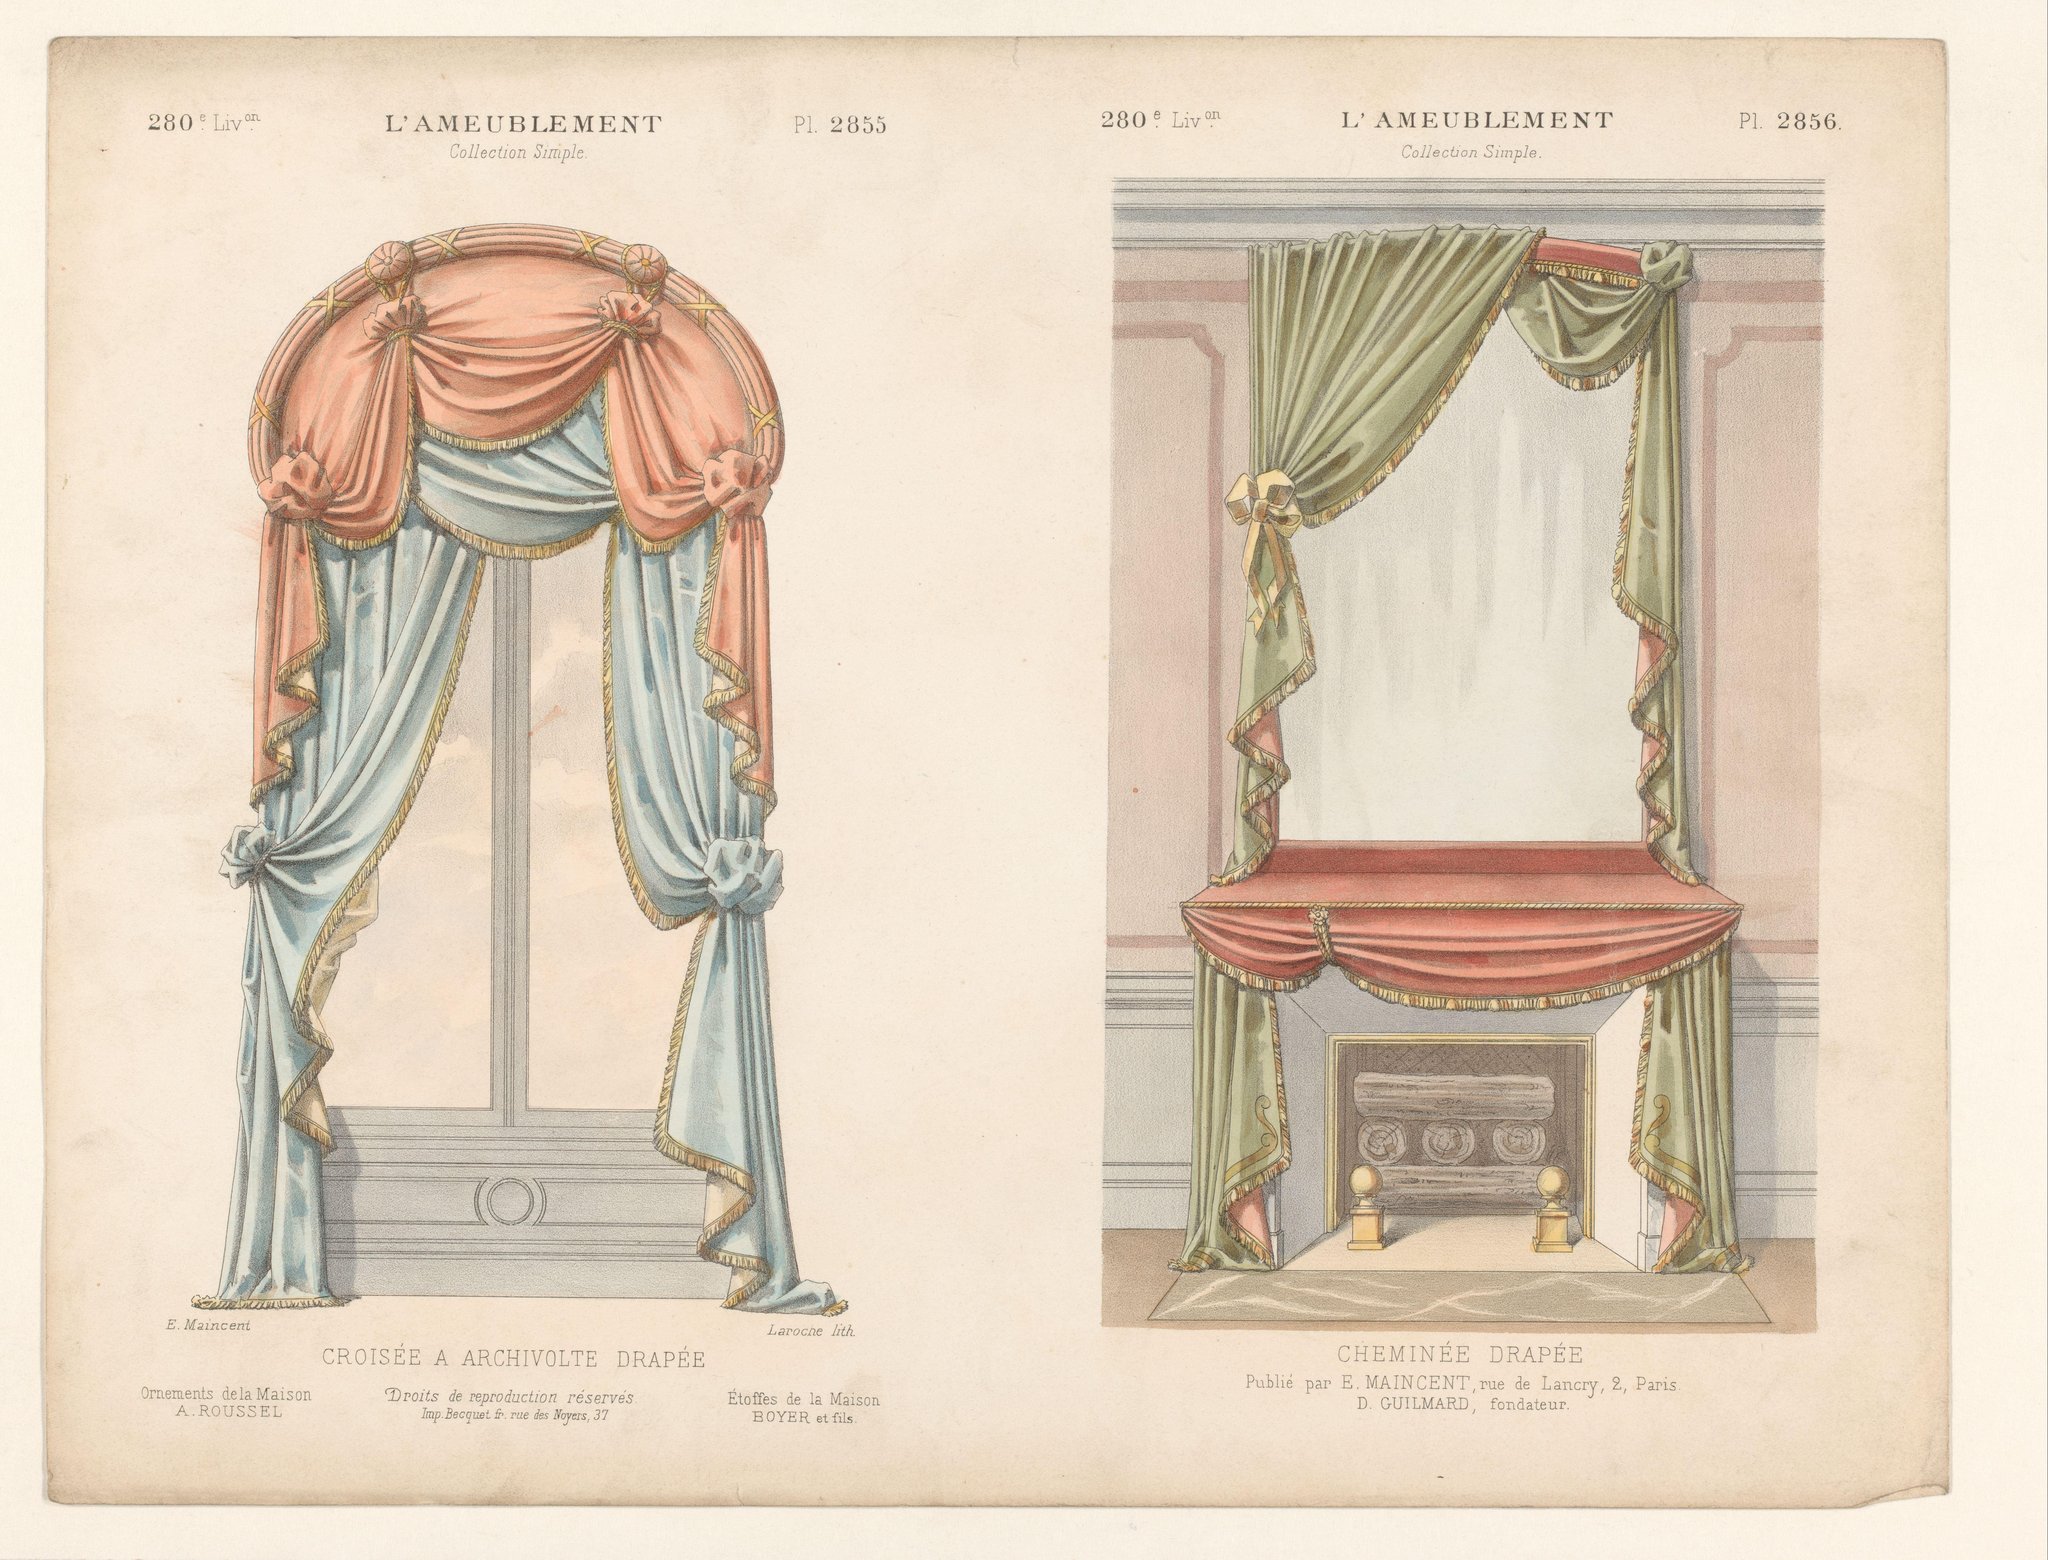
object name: print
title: Venster met gordijnen en schouw met draperieën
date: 1885-1895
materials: paper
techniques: hand coloring, lithograph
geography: paris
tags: chimney, window, hangings and drapery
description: Een venster met gedrapeerde gordijnen en een schouw met spiegel en draperieën. Prent uit 280e Livraison.